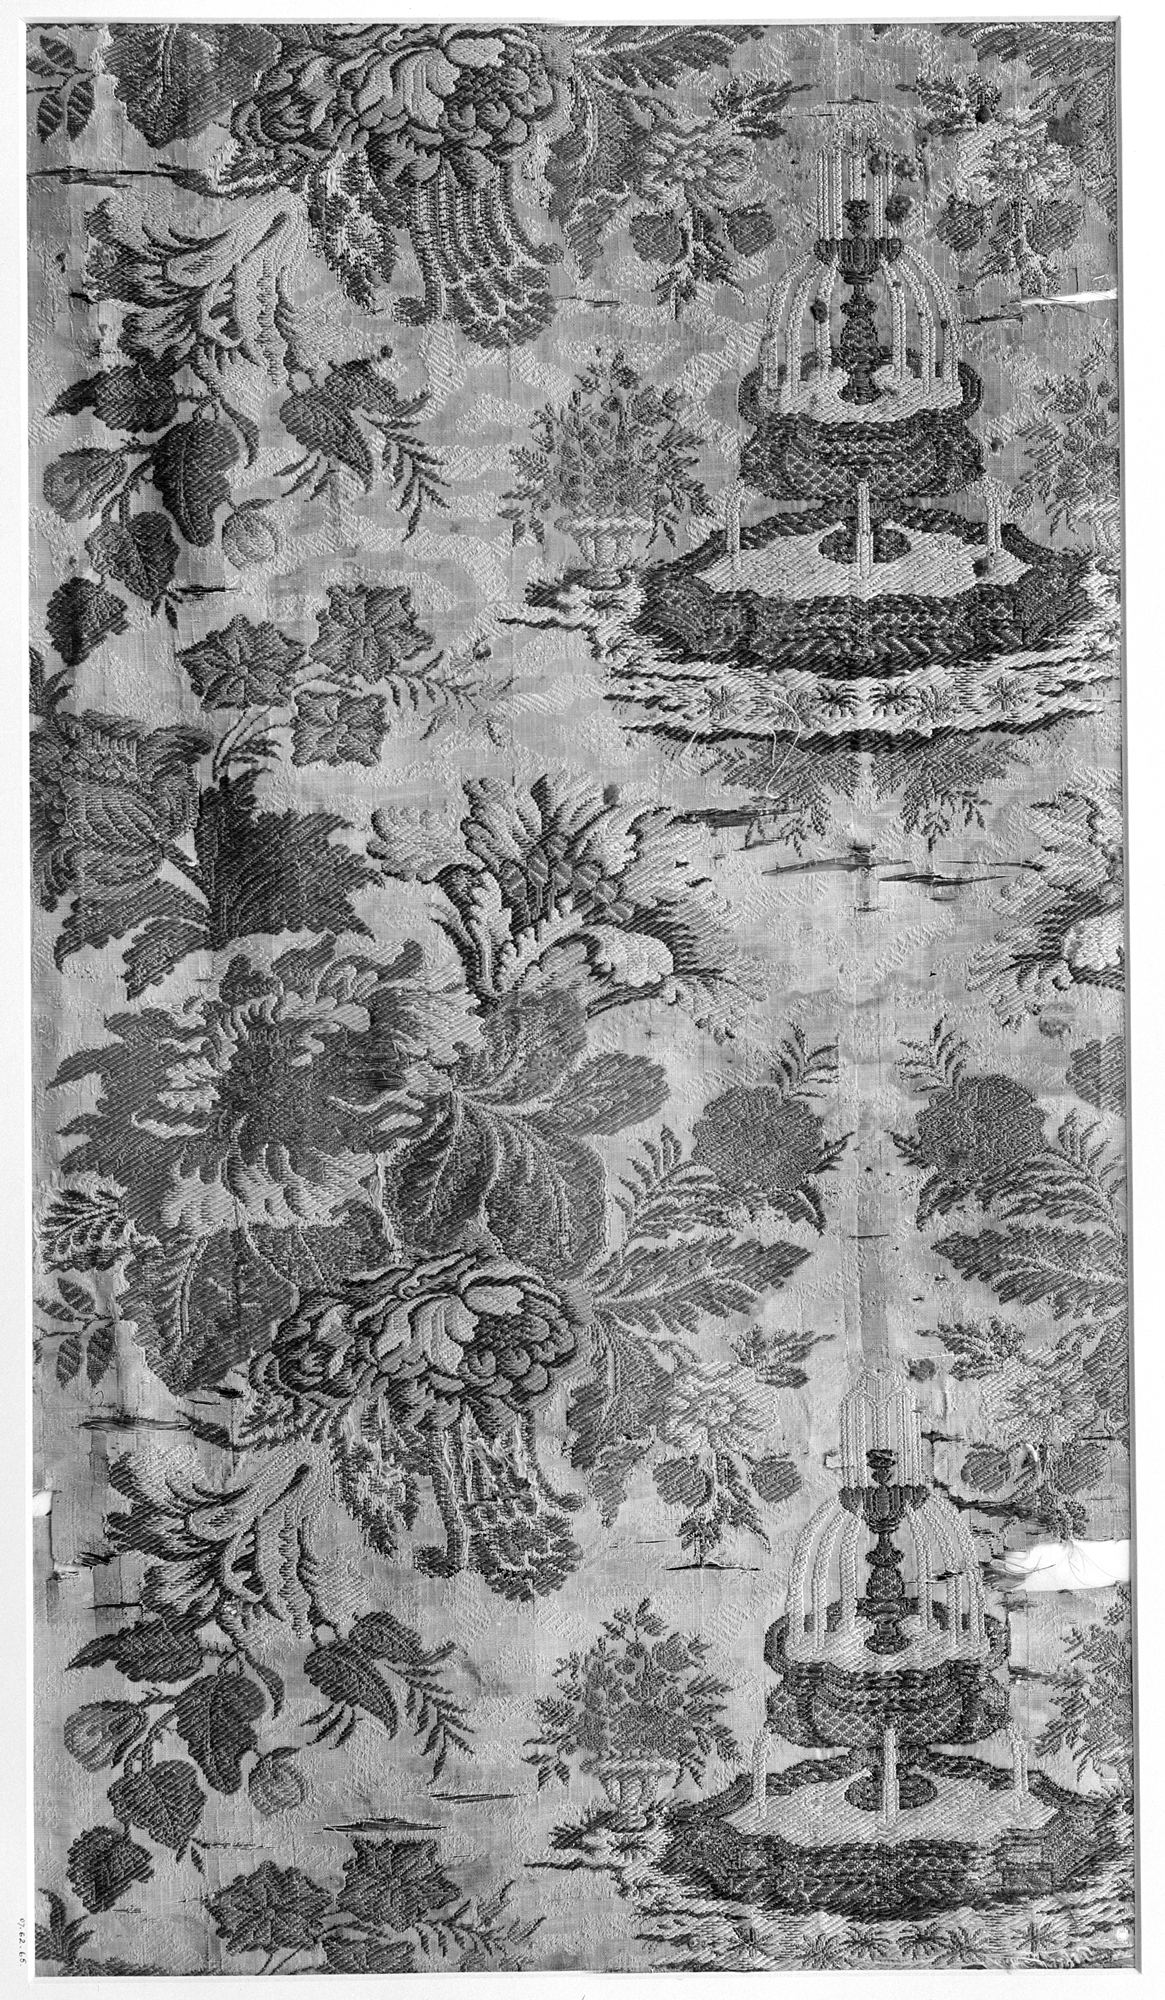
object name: piece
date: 1701-1733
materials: silk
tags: fountains,flowers,leaves